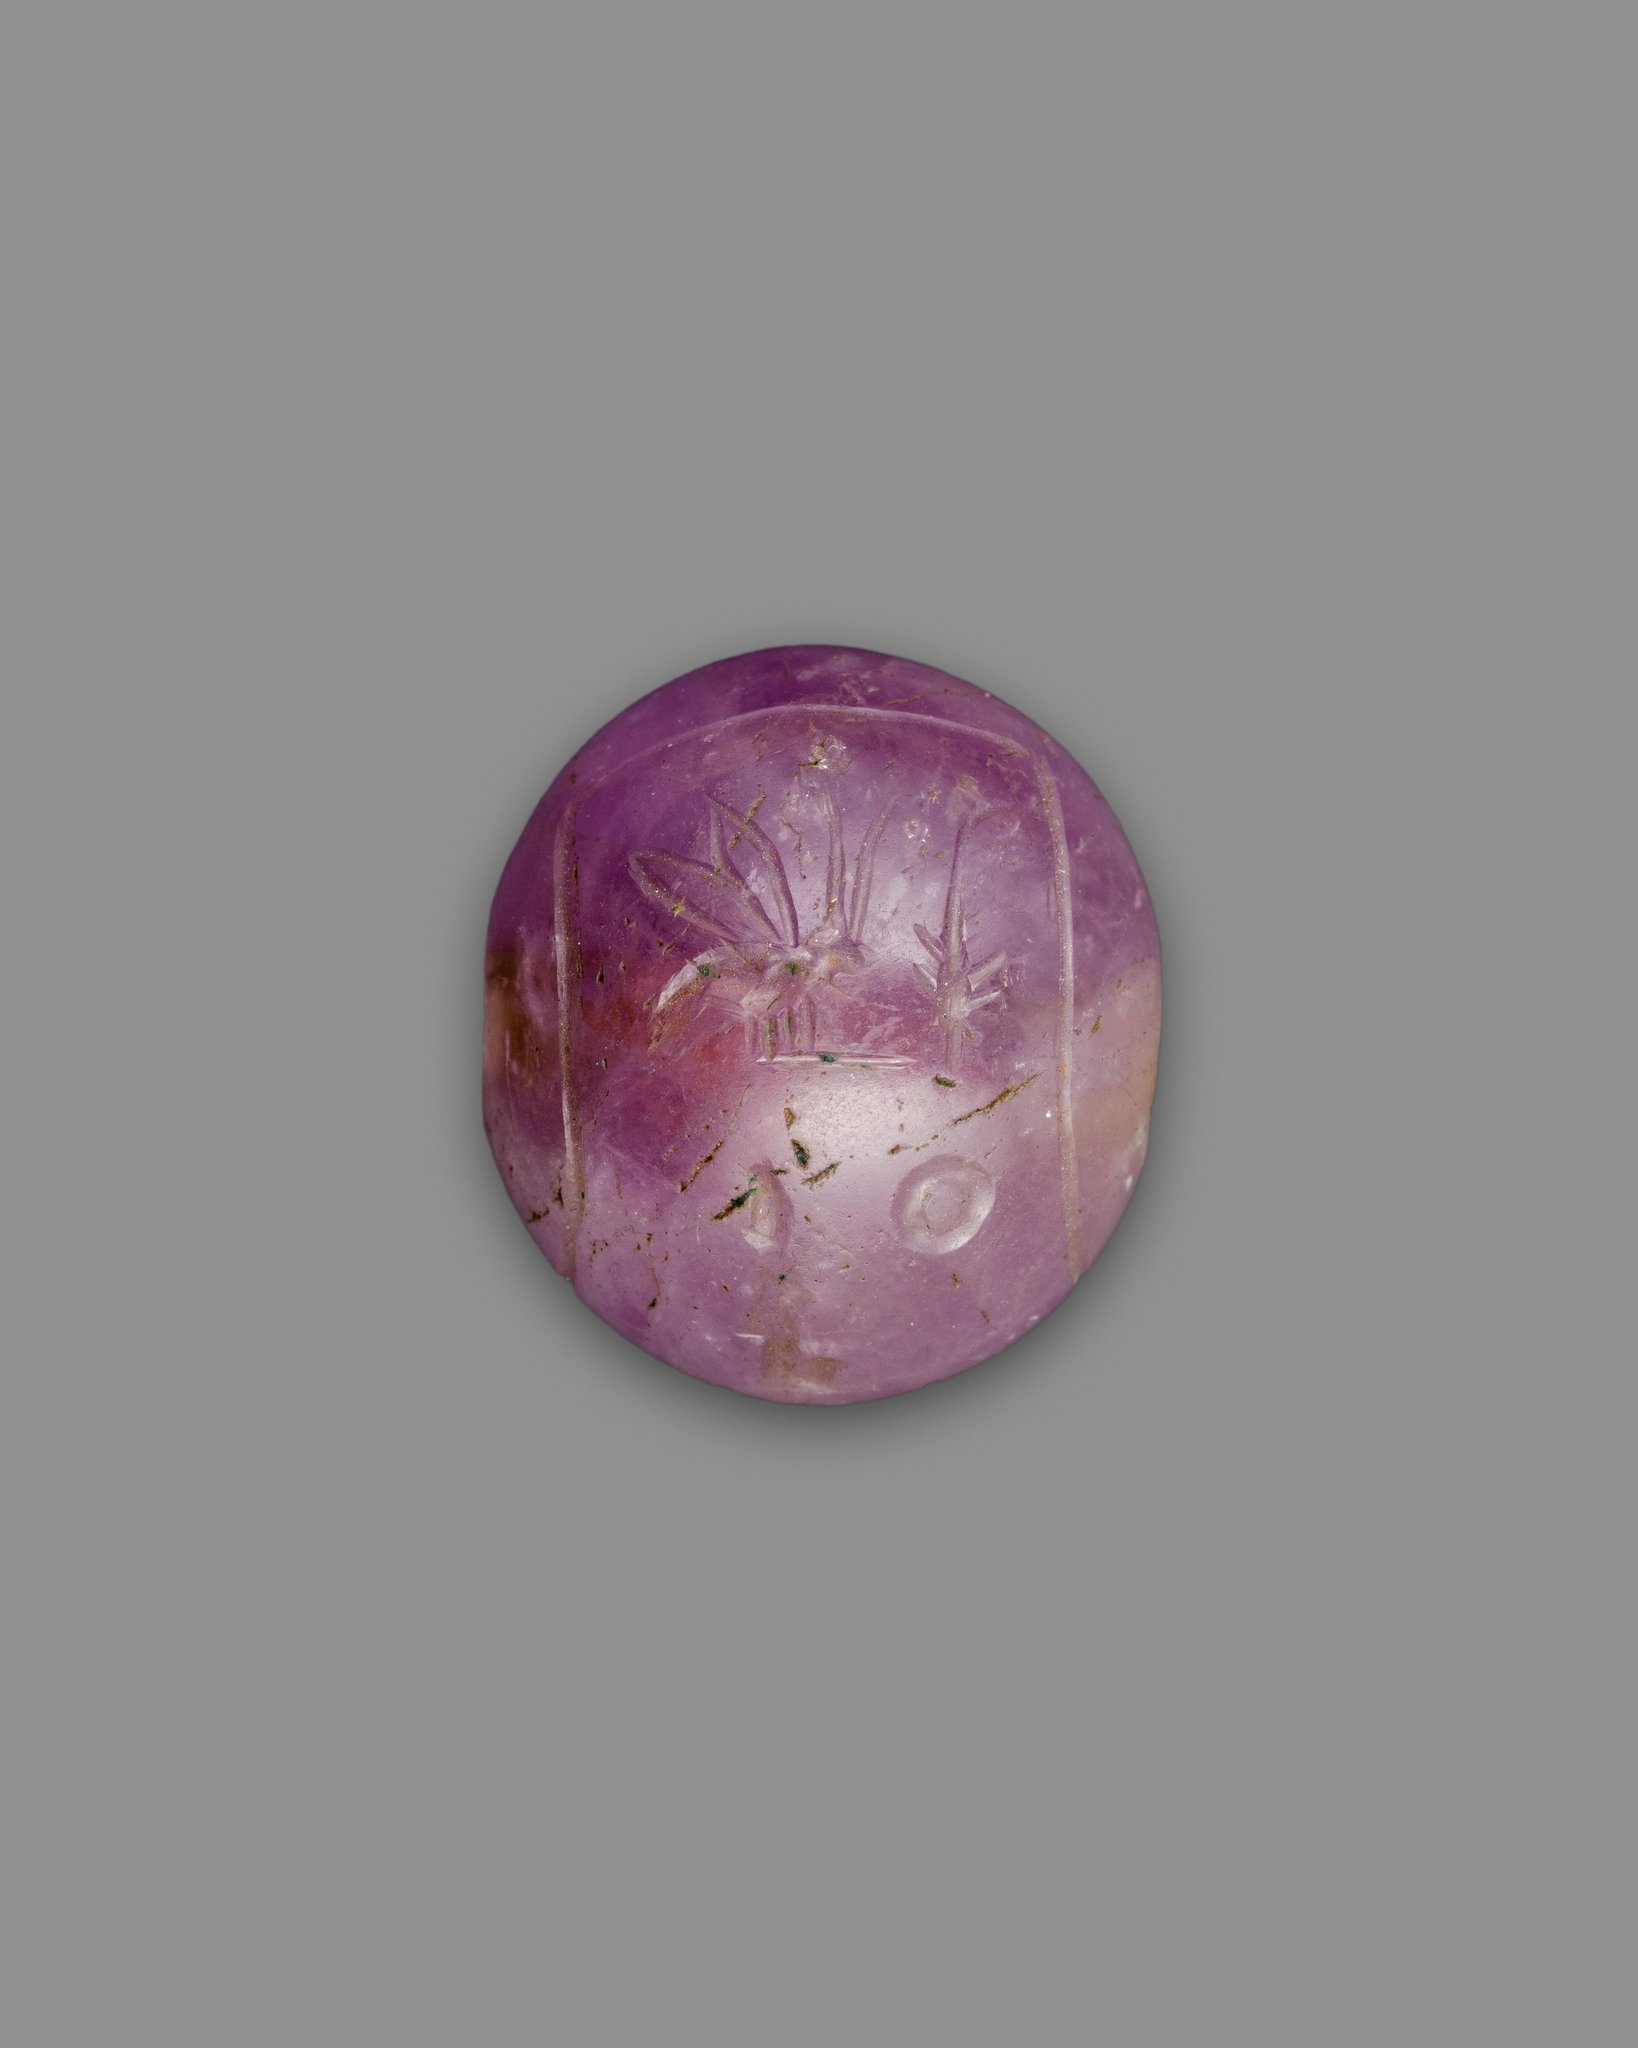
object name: bead, ball, hatshepsut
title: Ball Bead with Name of Hatshepsut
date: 1479-1458 BCE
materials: gemstone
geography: egypt